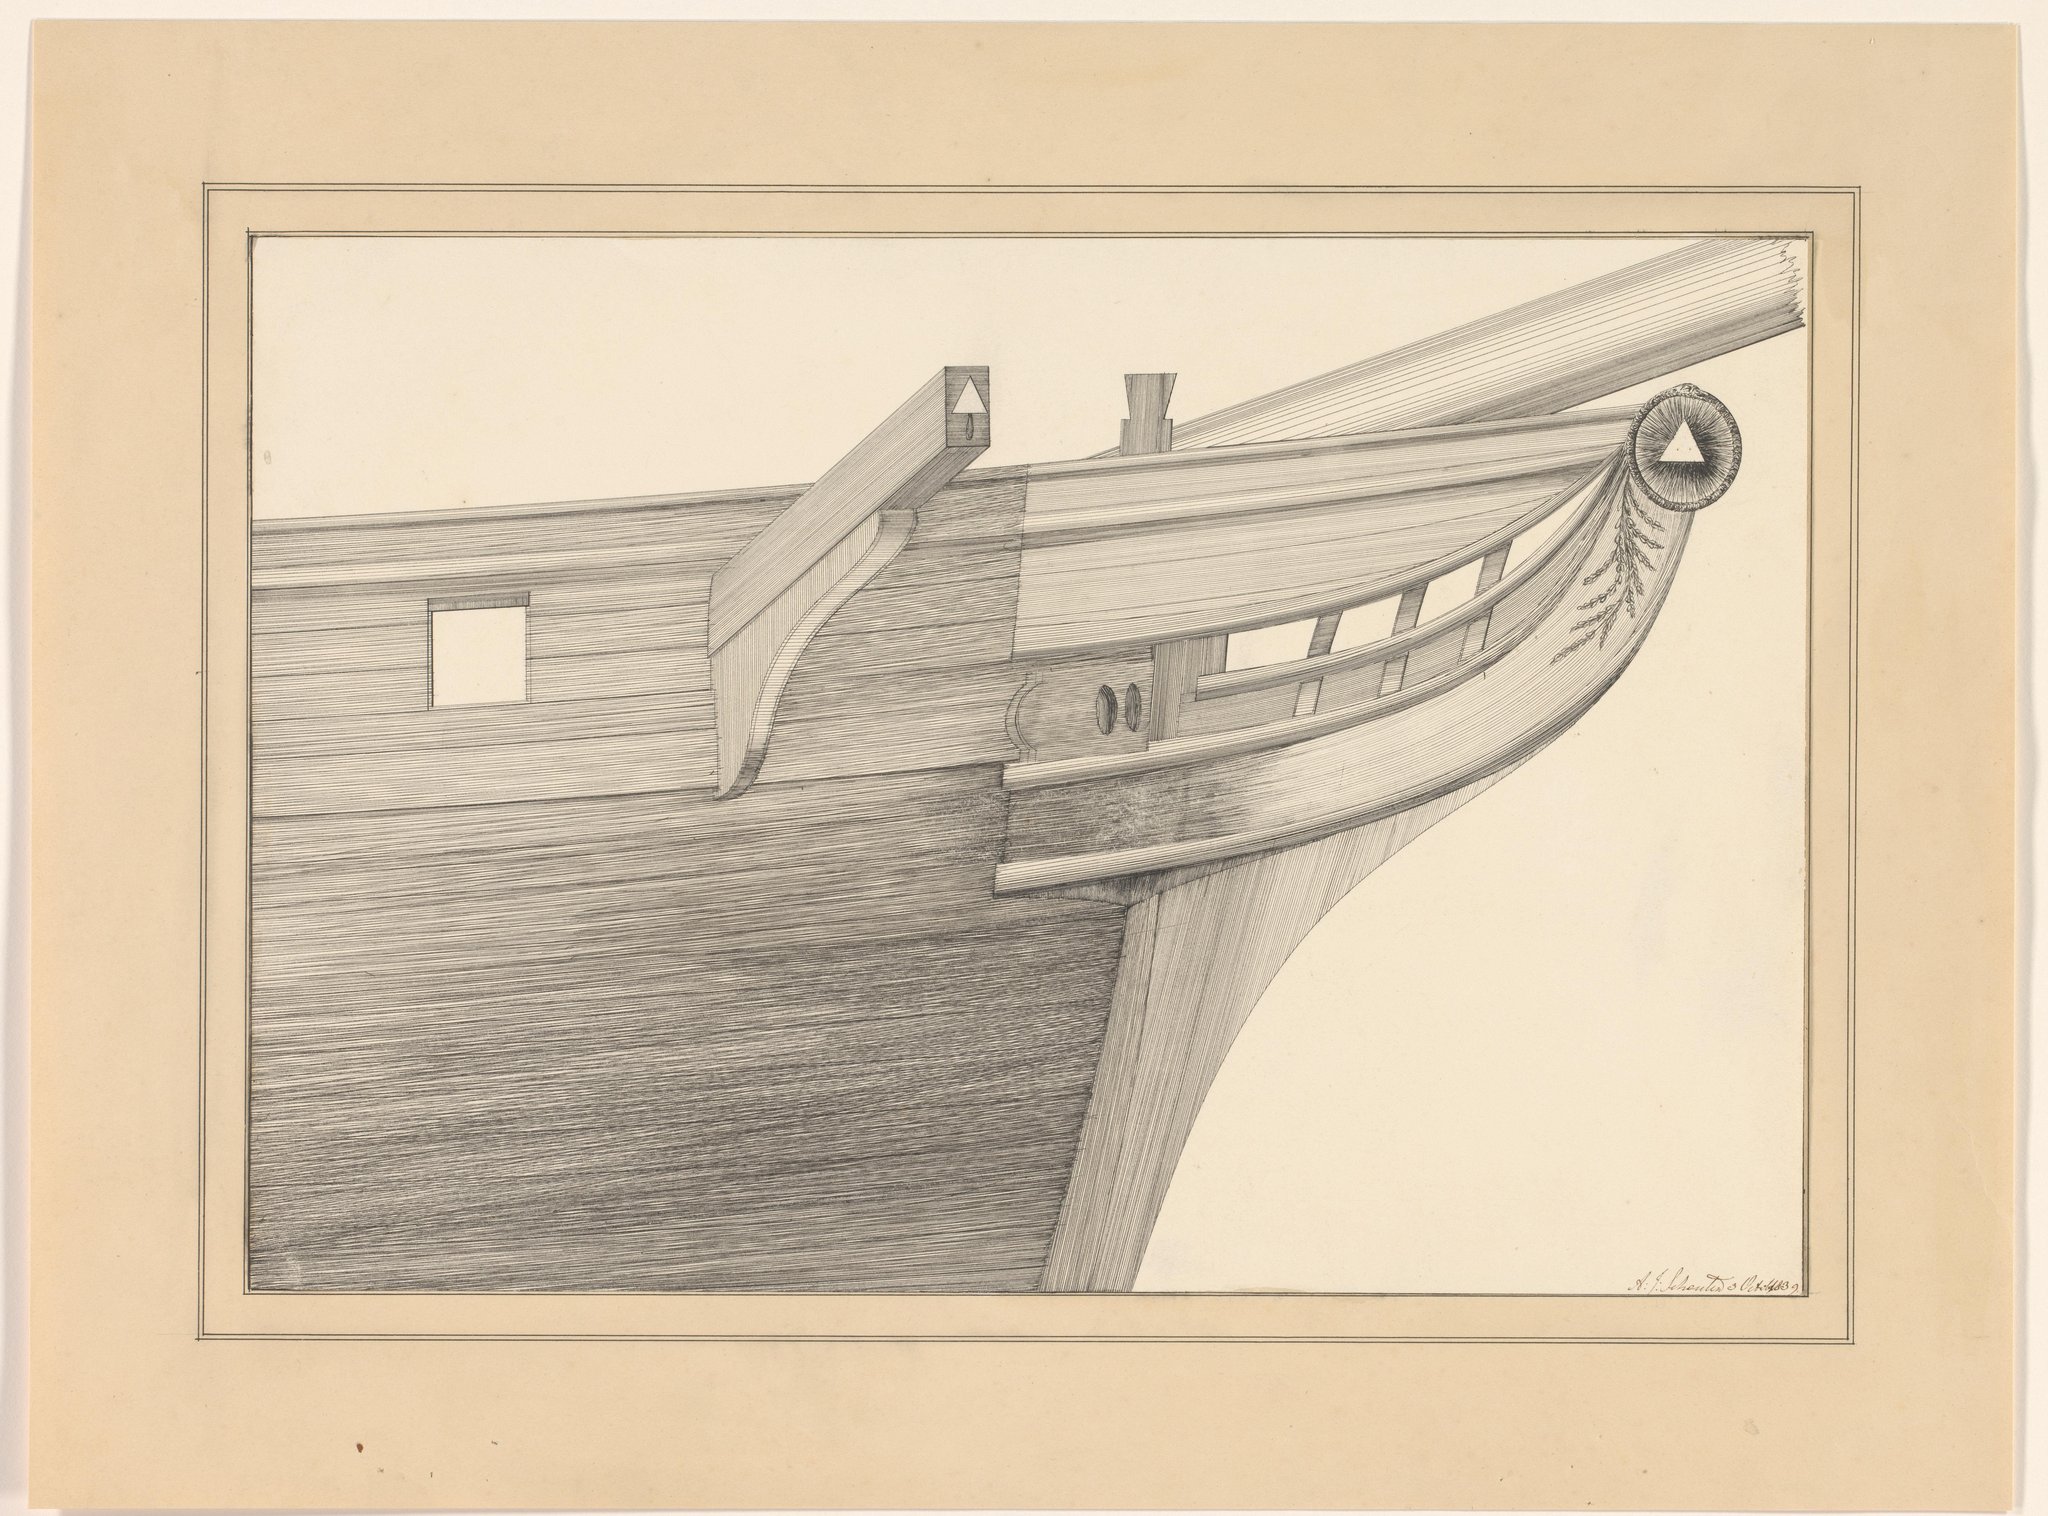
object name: design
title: Ontwerp voor de versiering van de boeg van het fregat Delta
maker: a.j. schouten (1775-1849)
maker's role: architect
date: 1839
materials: ink, paper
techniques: pen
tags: parts of ship's exterior: bow, ornamenting, decorating ~ applied arts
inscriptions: inscription: ‘Koopvaardijfregat Delta’